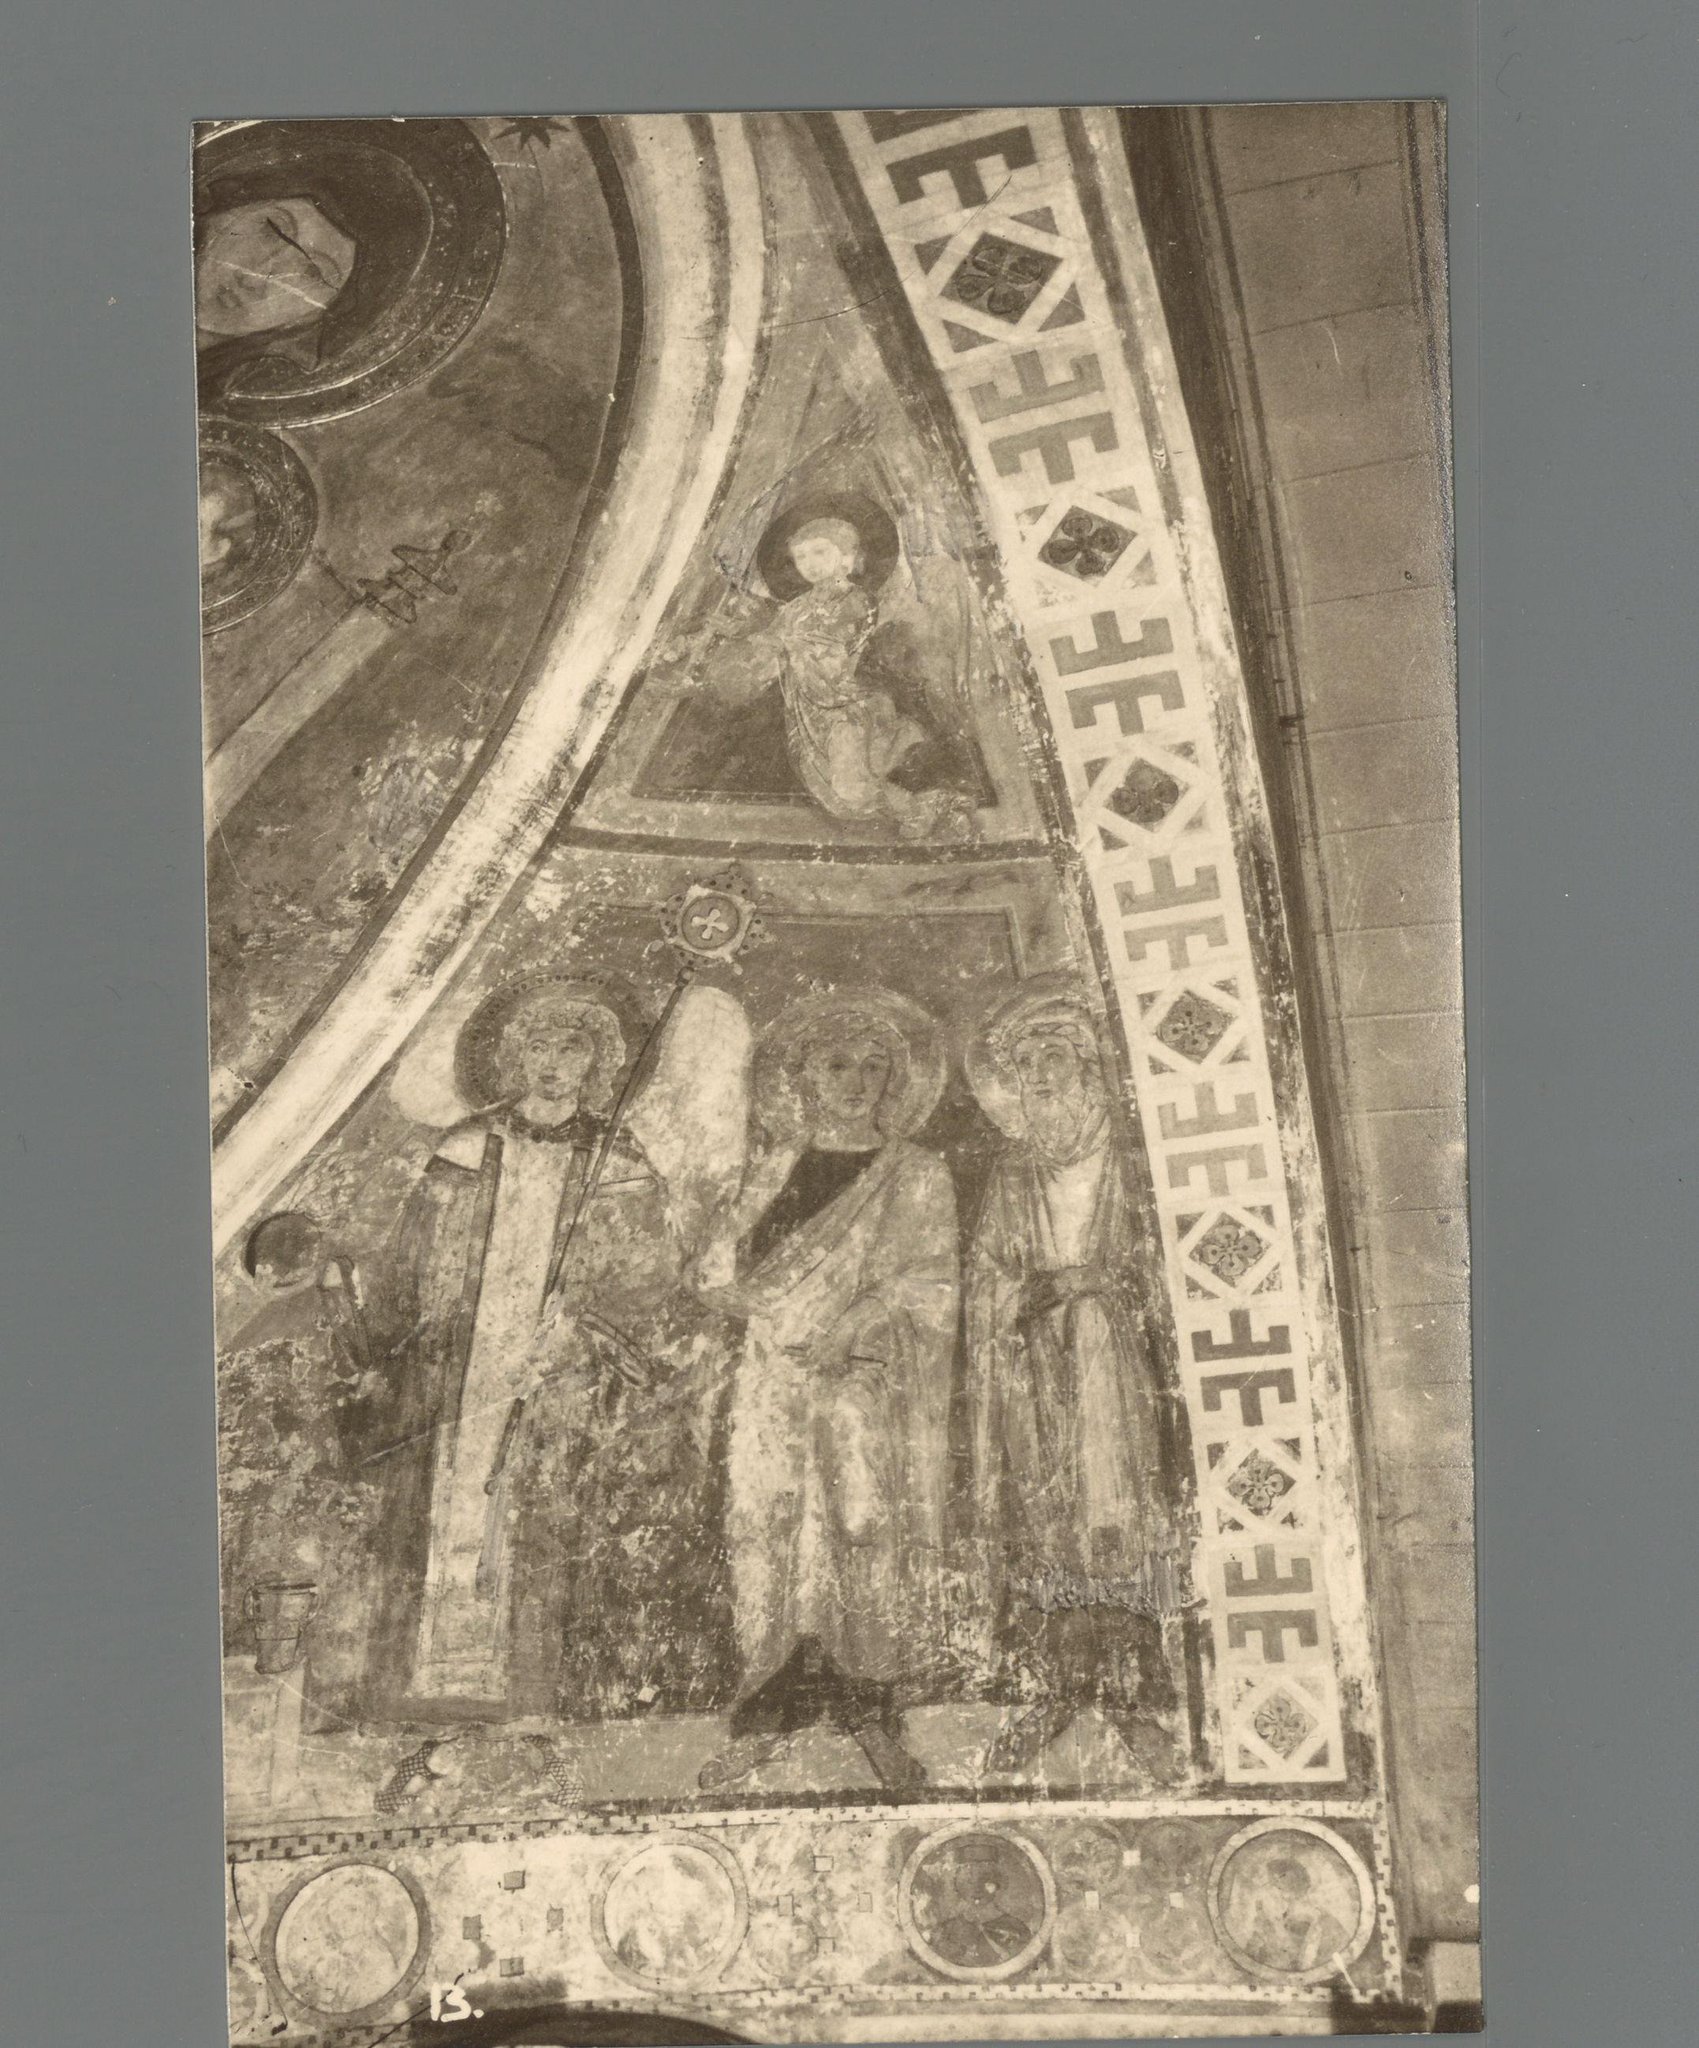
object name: ansichtkaart, prentbriefkaart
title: Plafondschildering in een kerk in Soest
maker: w. lange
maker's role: fotograaf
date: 1905-1930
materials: photographic support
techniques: gelatin silver print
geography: soest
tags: interior of church, picture, painting